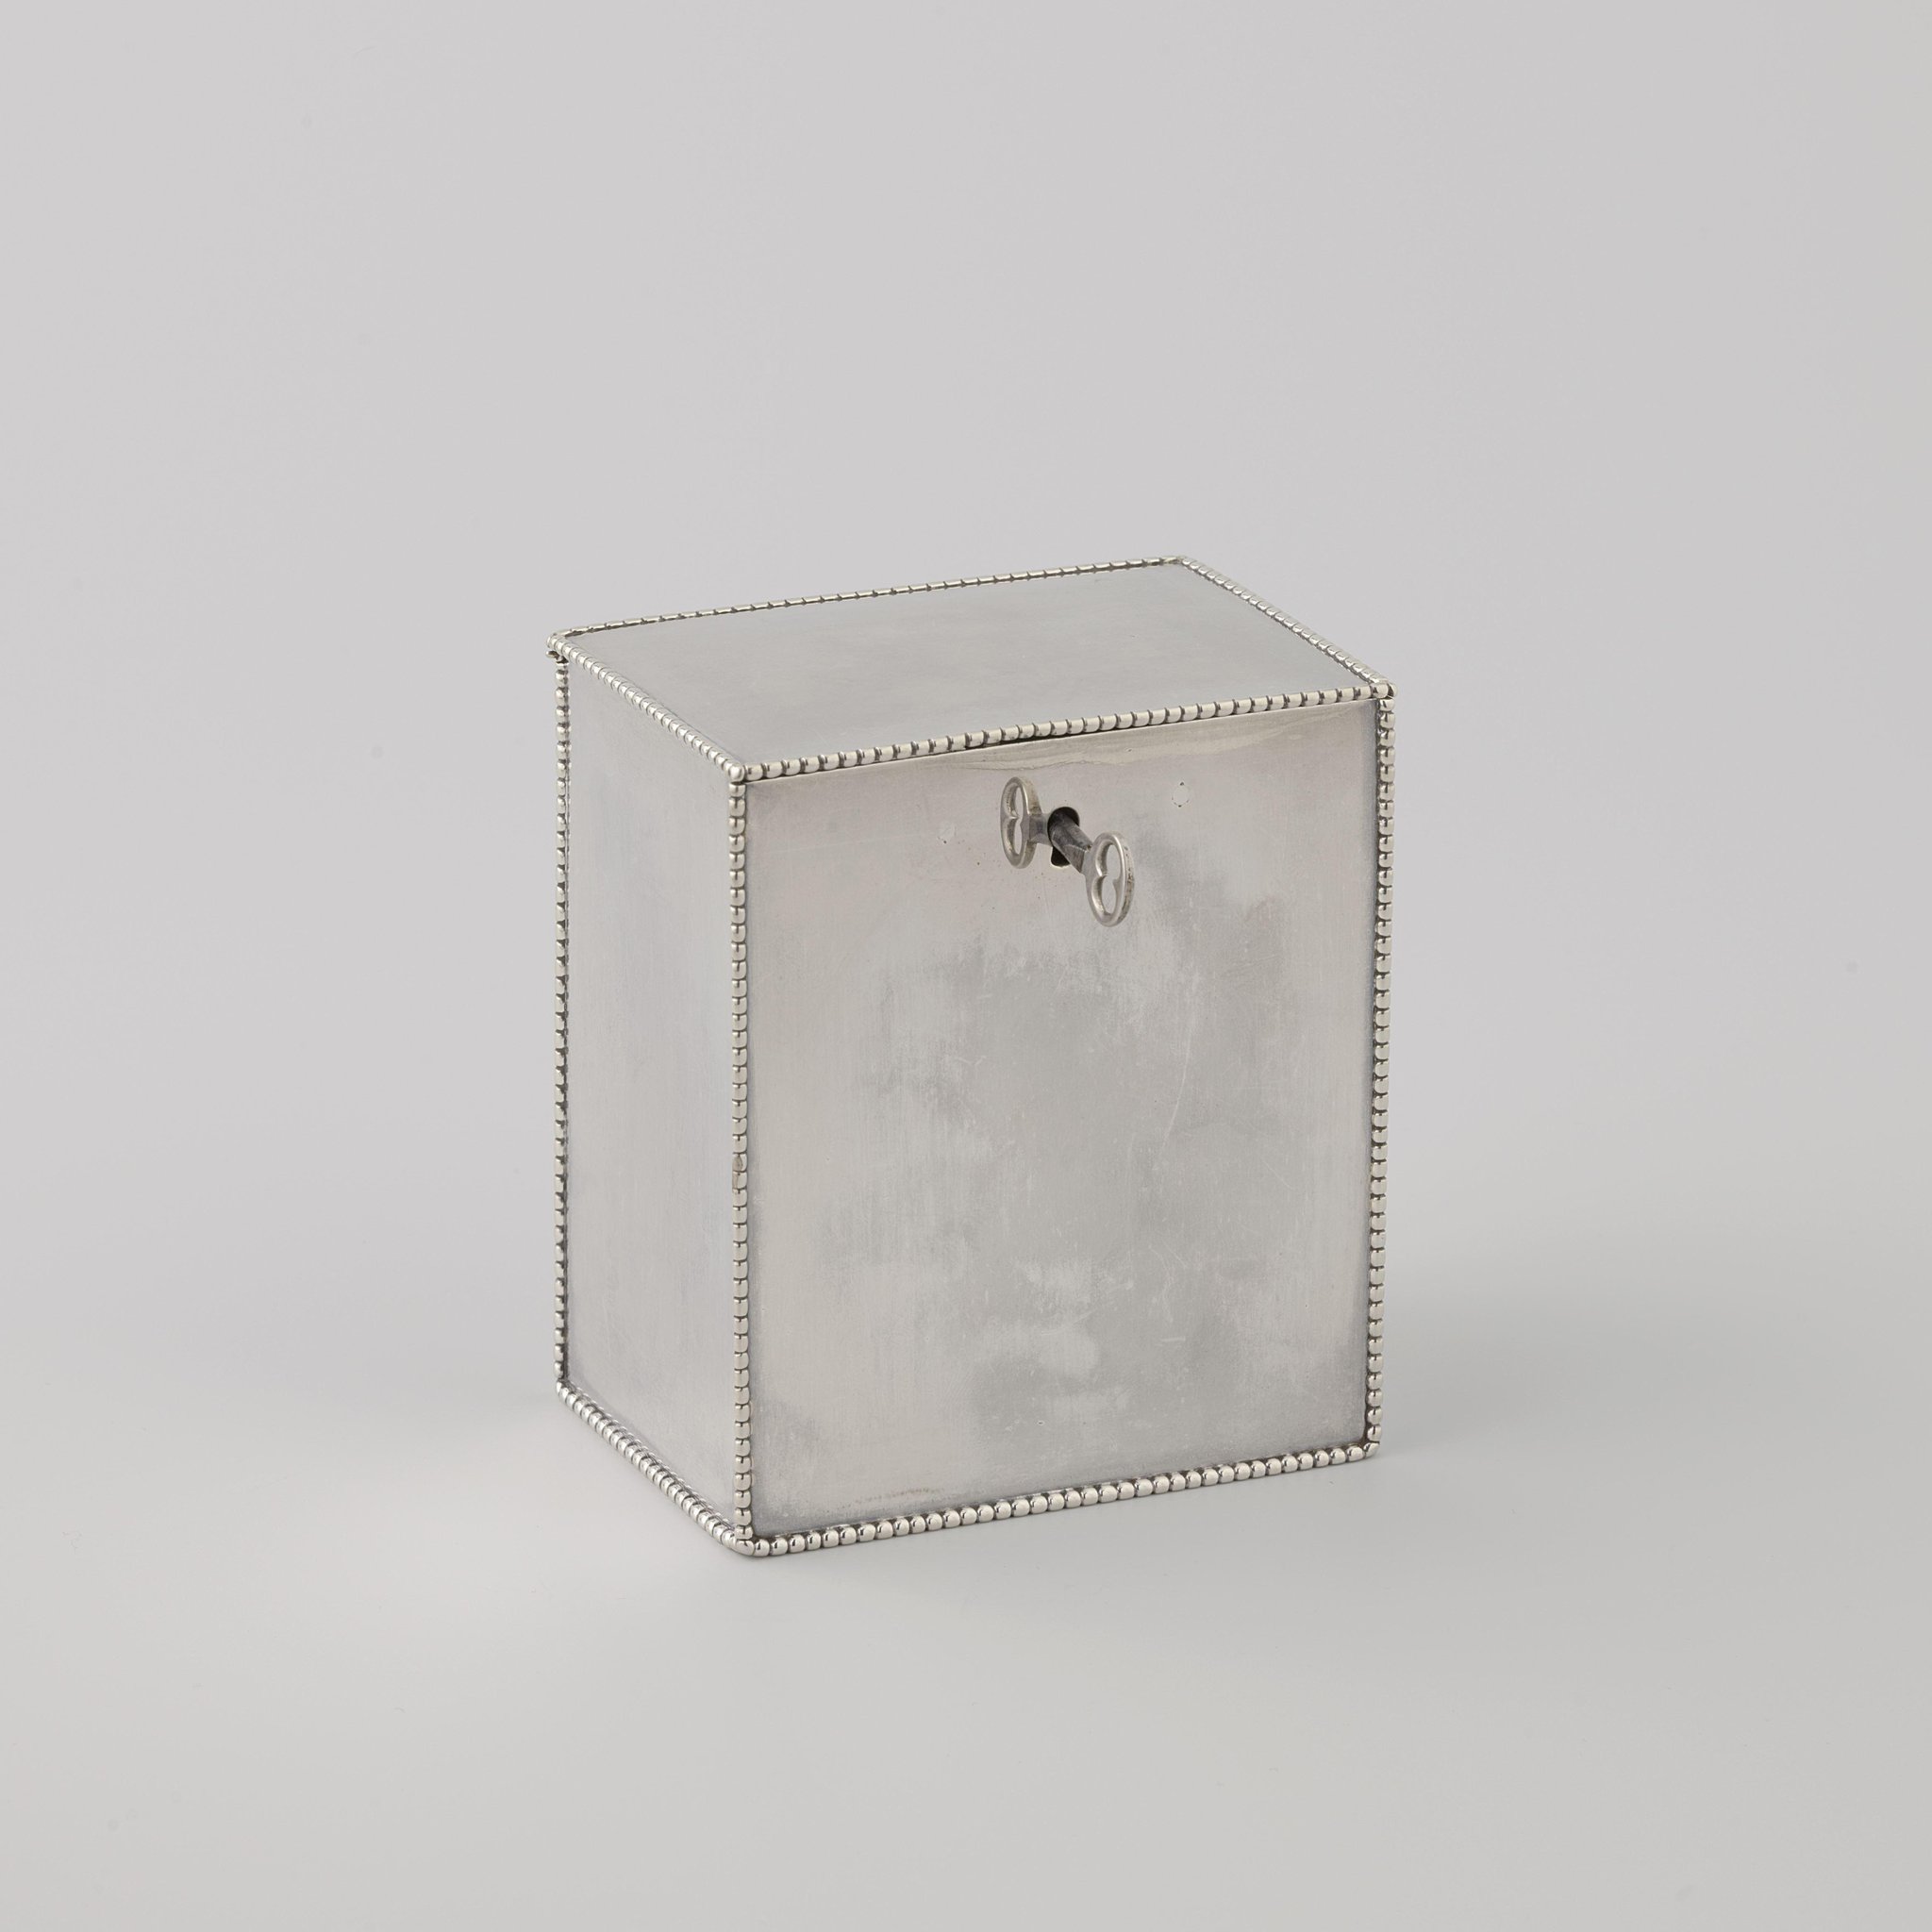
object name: tea caddy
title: Theebus, rechthoekig, met parelranden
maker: reynier brandt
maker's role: silversmith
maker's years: 1707-1788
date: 1782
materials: silver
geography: amsterdam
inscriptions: alloy mark, redemption mark: ‘N’, maker's mark, town mark, duty mark: ‘V’, date letter: ‘X’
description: De rechthoekige theebus heeft een vlak, scharnierend deksel. Langs alle randen zijn parellijsten aangebracht. De bus is voorzien van een slot, waarvan de sleutel ontbreekt.